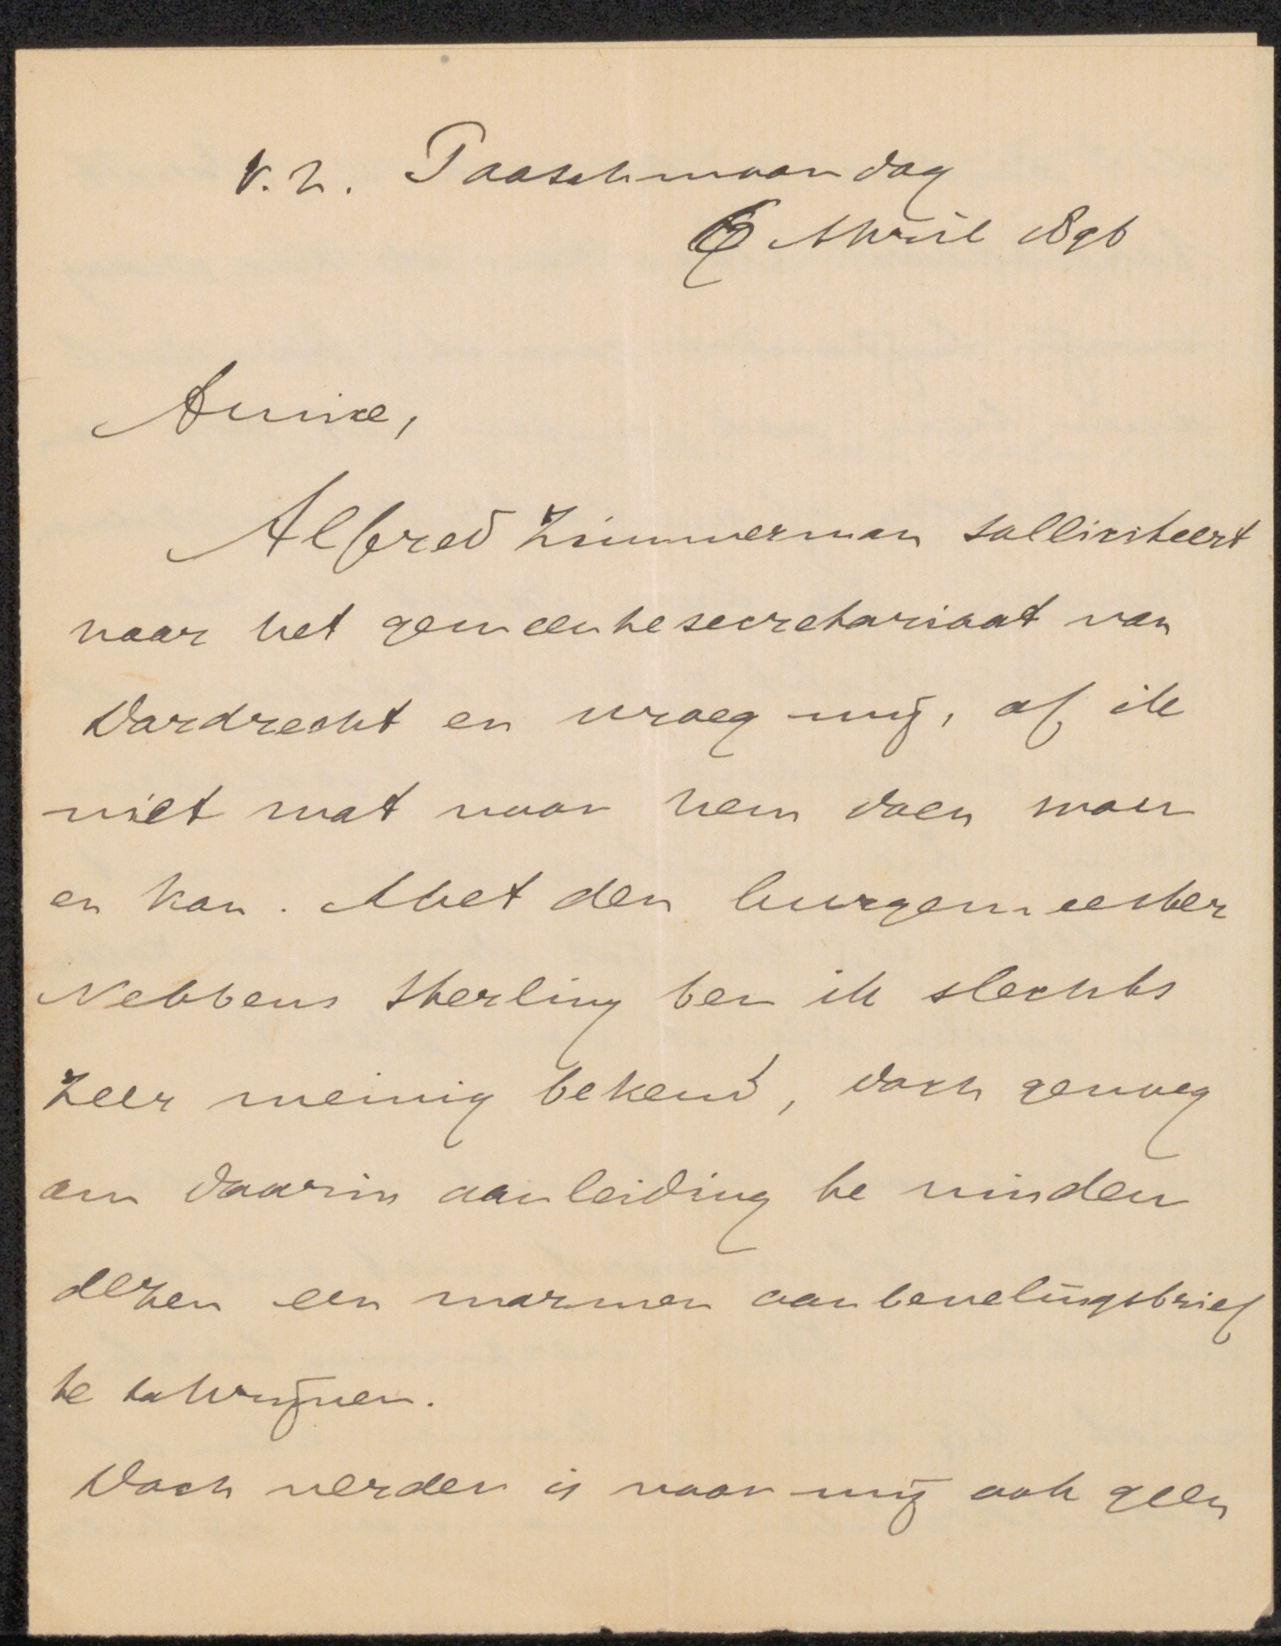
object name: letter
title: Brief aan Jan Veth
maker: jacob pieter moltzer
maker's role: jurist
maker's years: 1850-1907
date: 1896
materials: ink, paper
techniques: pen, writing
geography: the hague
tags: politician, mayor, alfred rudolph zimmerman, dordrecht, painter, print maker, draughtsman, designer, jan veth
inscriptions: collector's mark: ‘RPK’